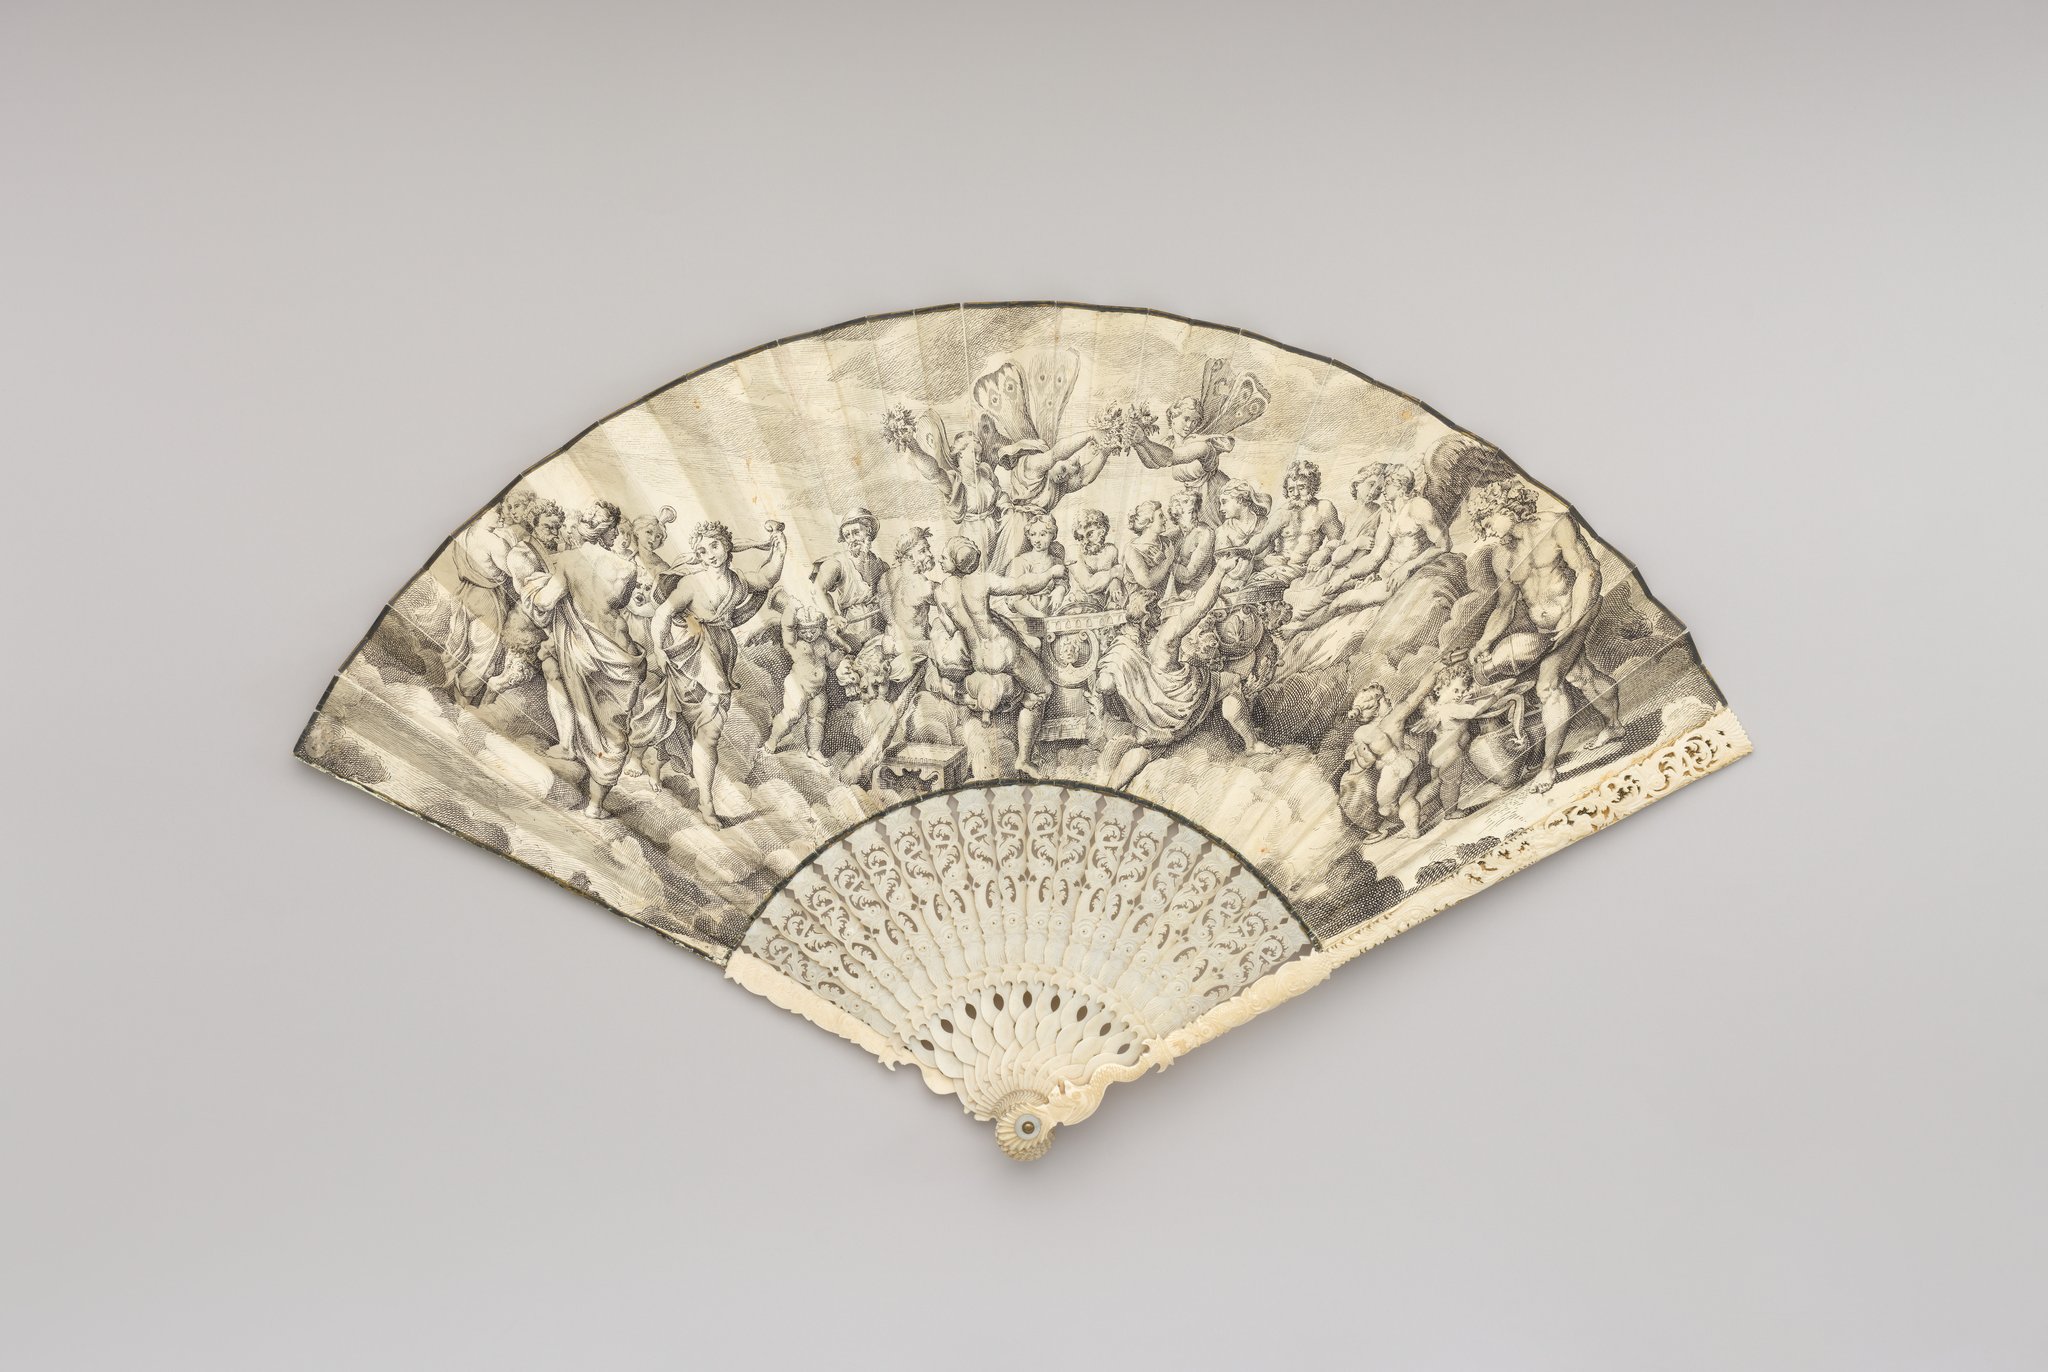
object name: fan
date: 1701-1800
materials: ivory, skin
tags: men,women,putti